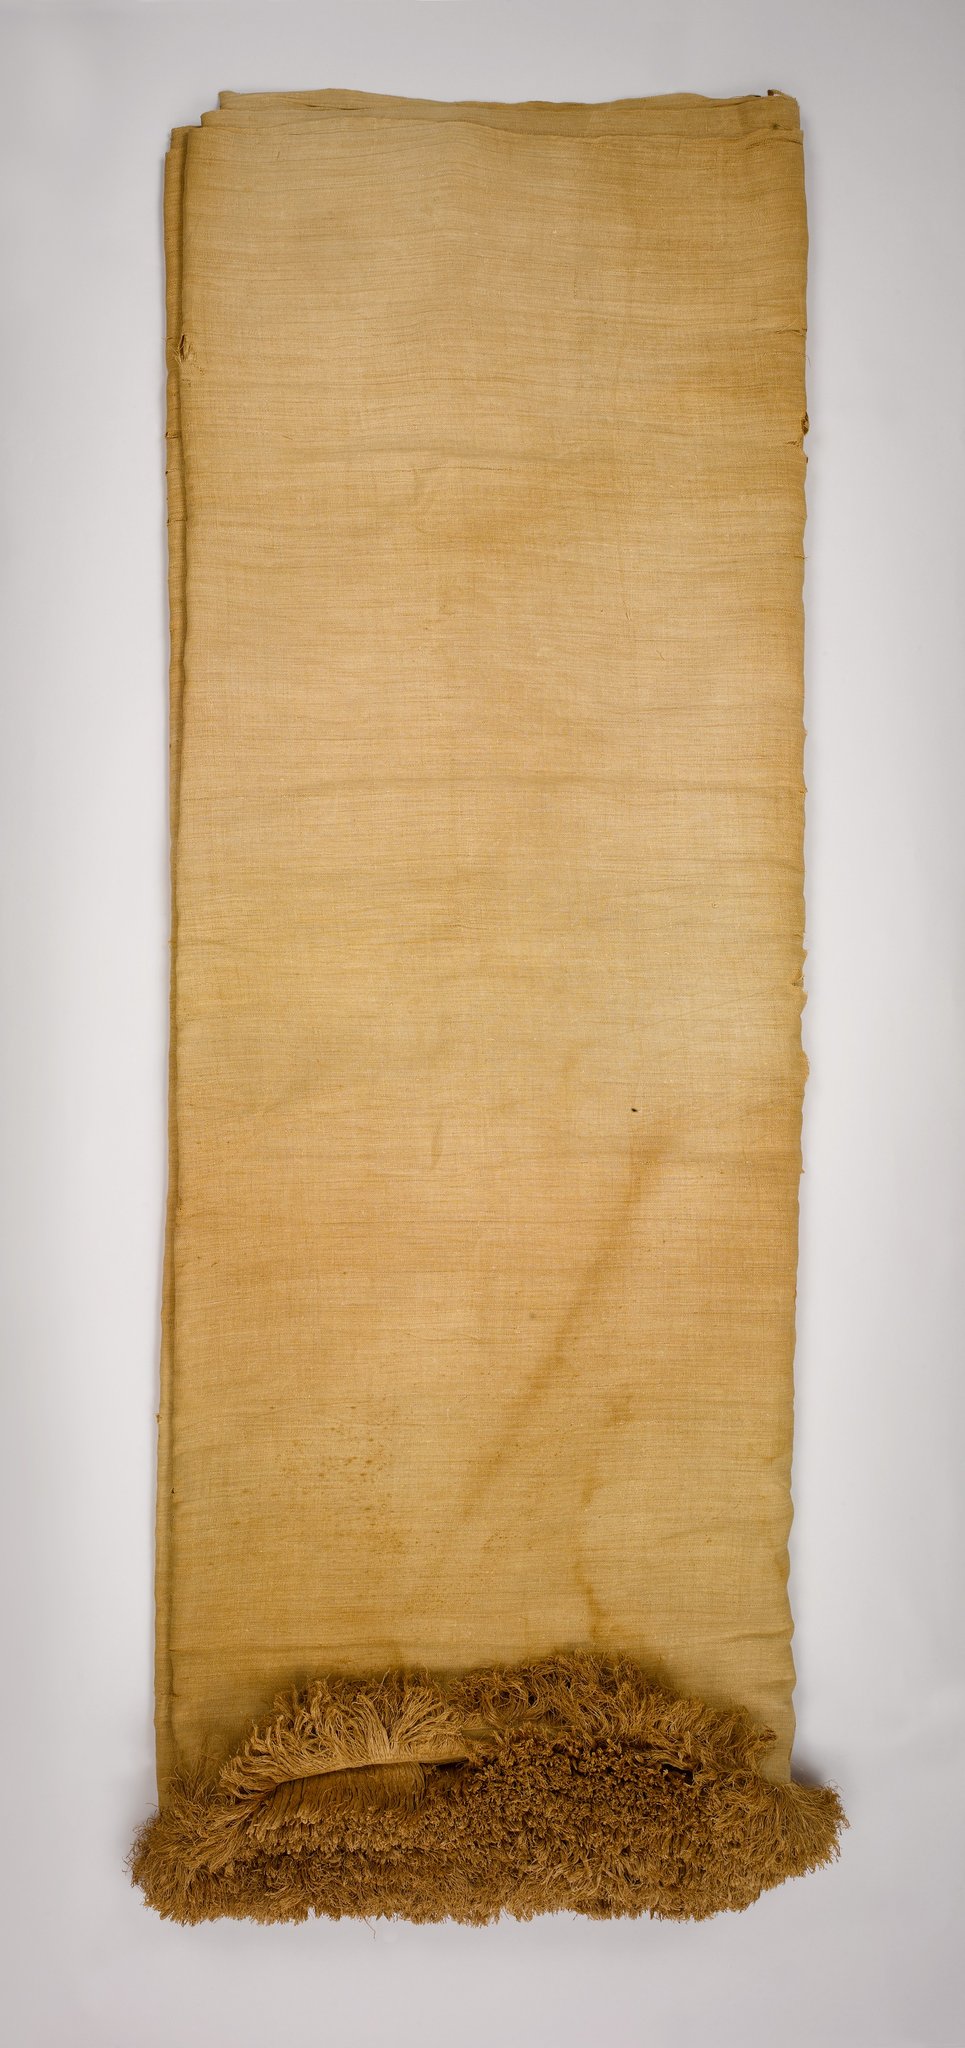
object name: linen sheet, myt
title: Linen sheet of Myt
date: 2051-2030 BCE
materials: linen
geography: egypt